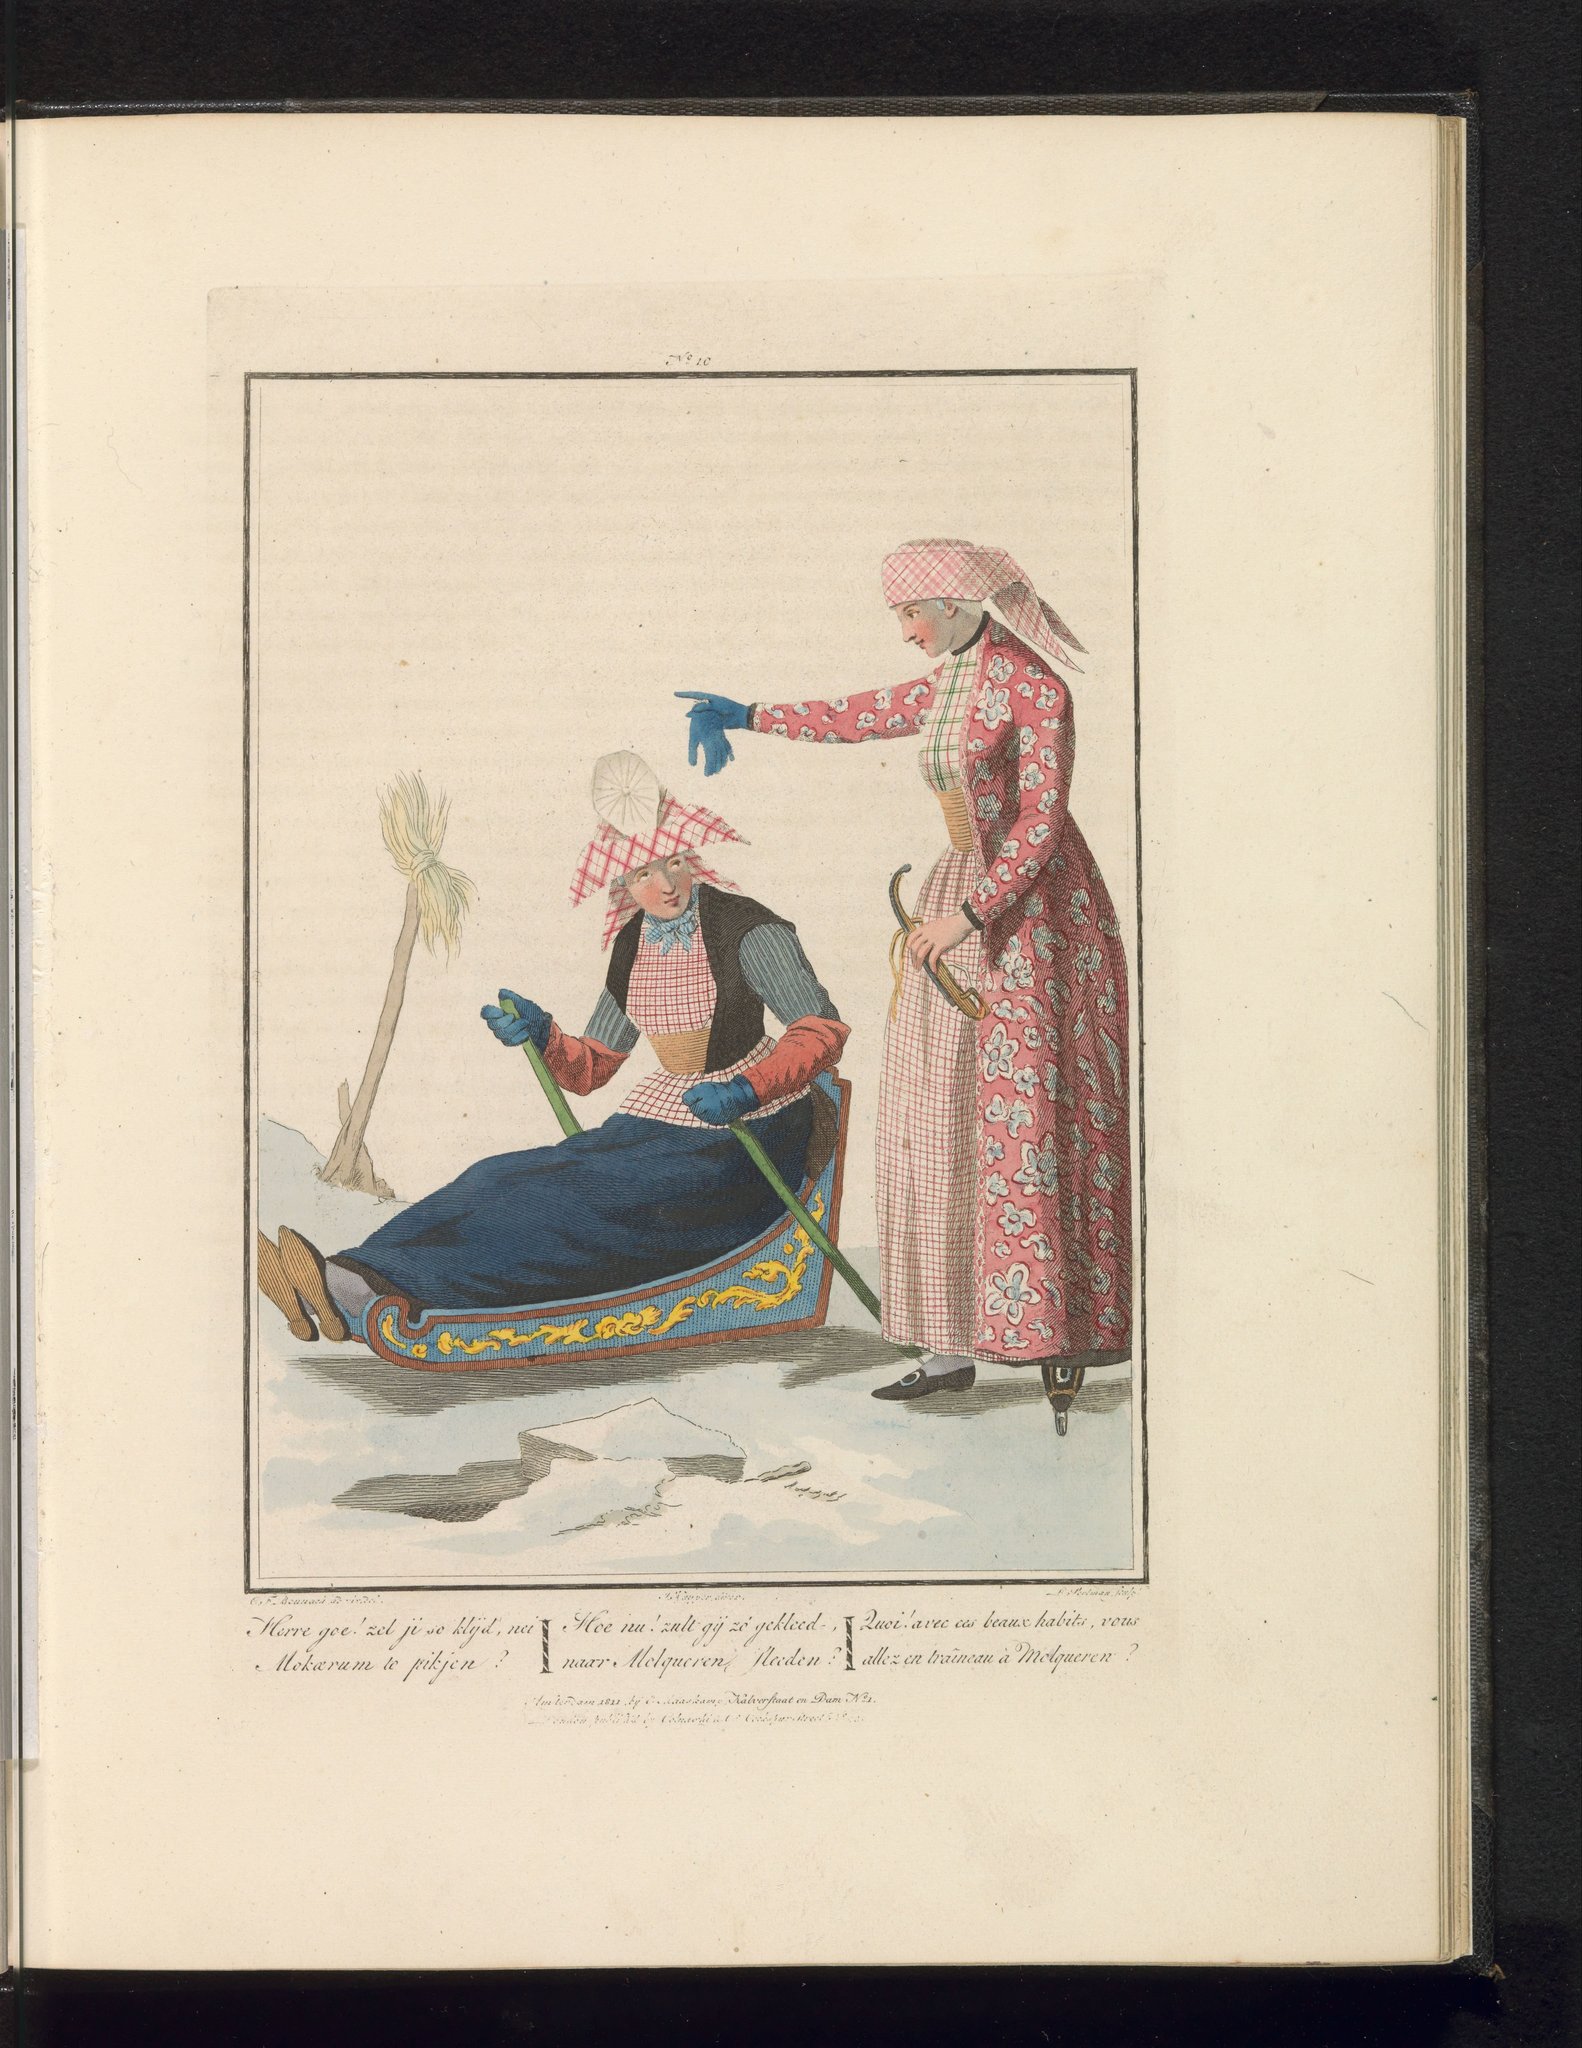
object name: print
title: Friese vrouwen op het ijs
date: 1804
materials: paper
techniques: etching, hand coloring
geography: london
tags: skates (winter sports), folk costume, regional costume, clothes, costume, small sleigh (winter sports)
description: Gebruikt als illustratie in: Evert Maaskamp, Afbeeldingen van de kleedingen, zeden en gewoonten in de noordelijke provincien van het Koningrijk der Nederlanden, met den aanvang der negentiende eeuw = Tableaux des habillemens, mœurs et coutumes dans les provinces septentrionales du Royaume des Pays-Bas, au commencement du dix-neuvième siècle. Amsterdam: Evert Maaskamp, 1829 [heruitgave van de oorspronkelijke platen eerst verschenen in 1803-1807].